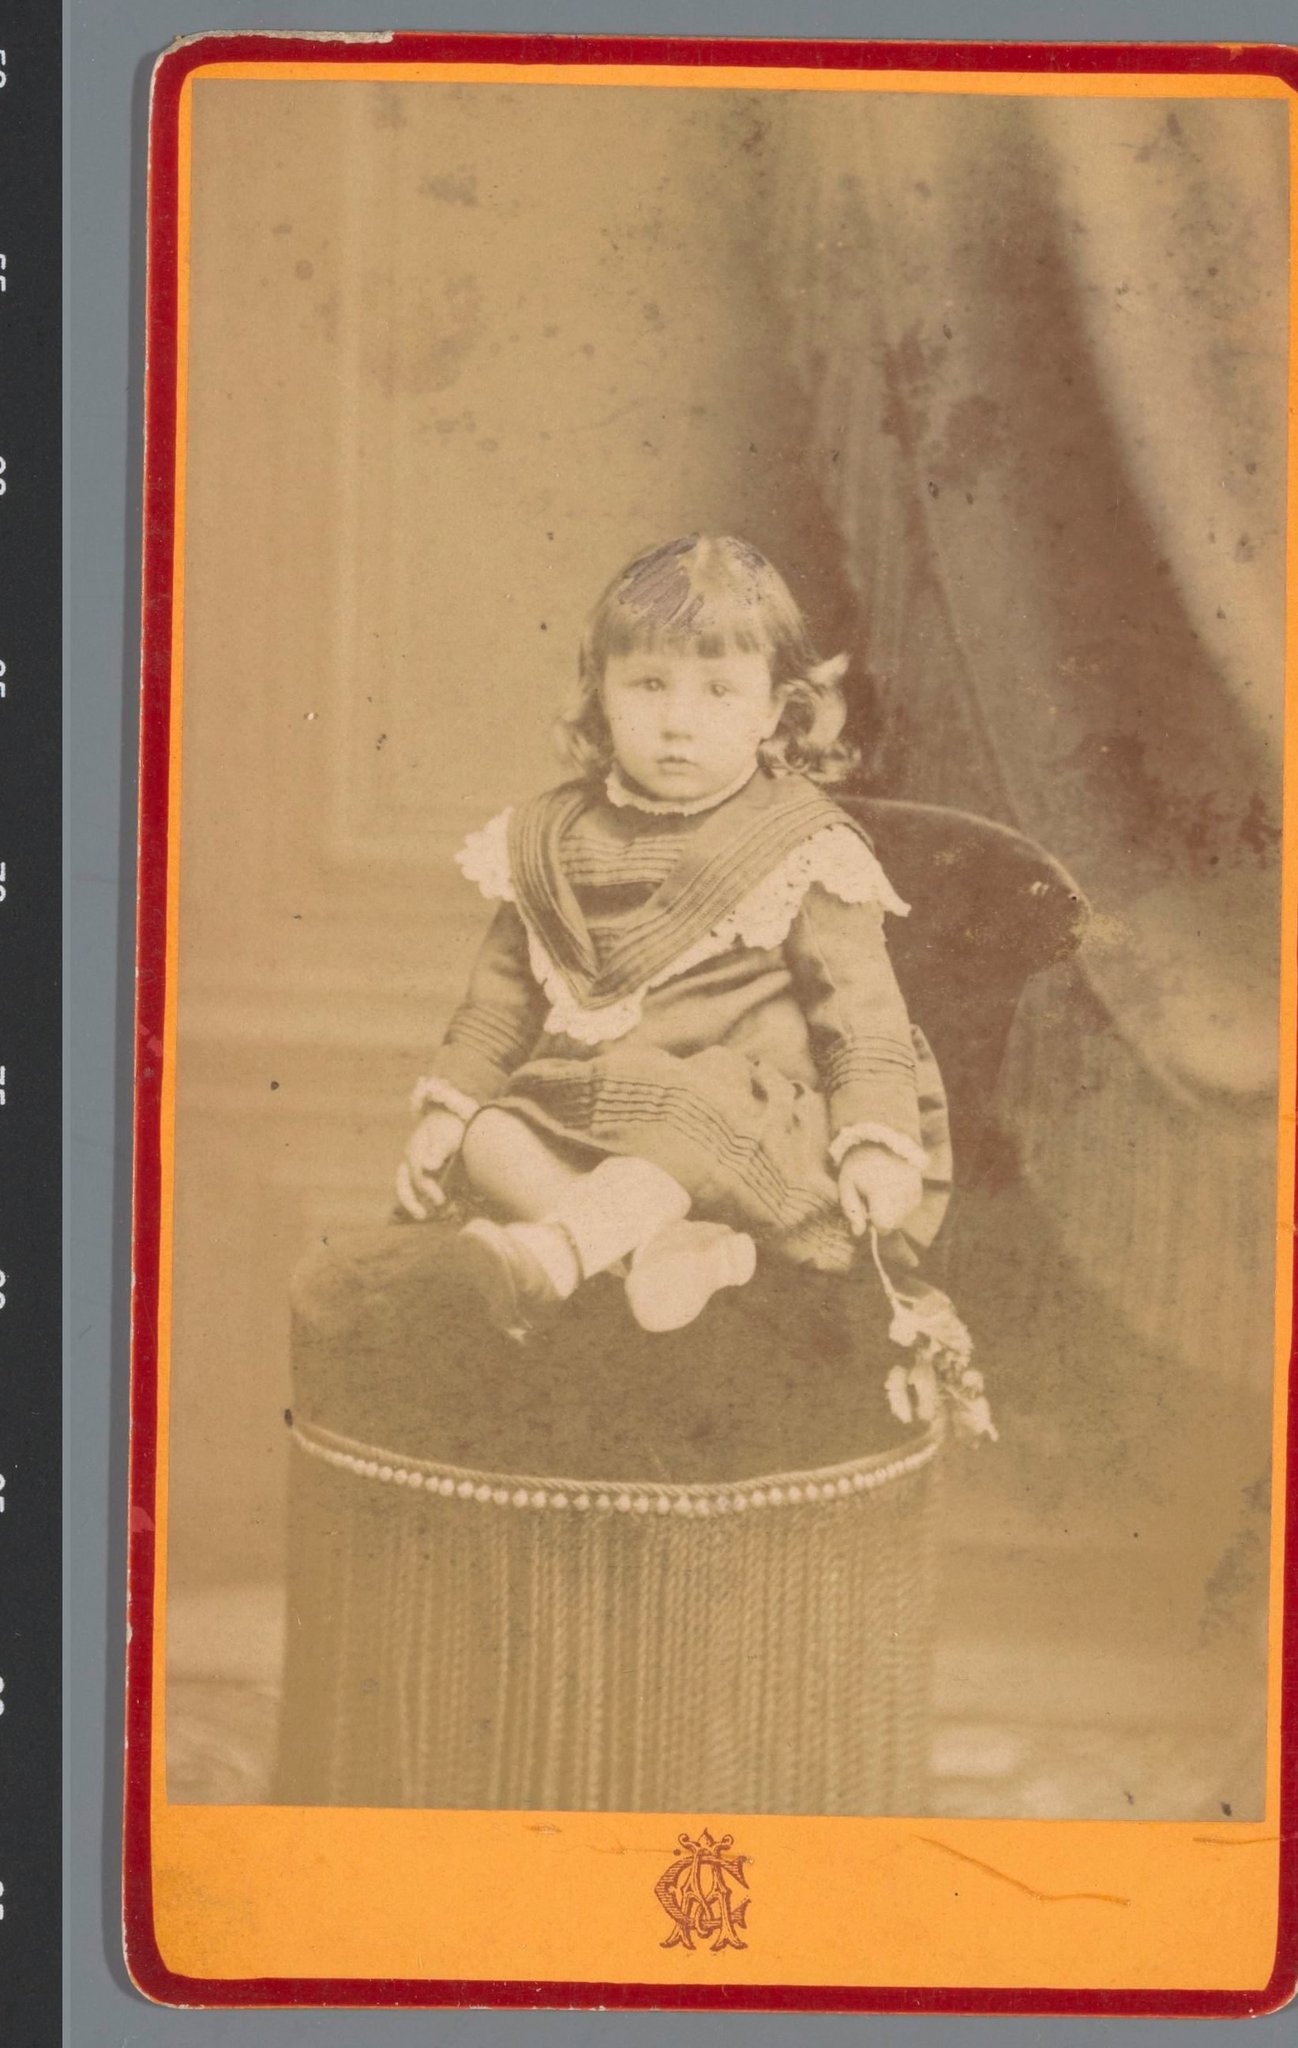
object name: carte de visite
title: Portret van een onbekend kind op een stoel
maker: angelo maria alessio caccia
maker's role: fotograaf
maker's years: 1802-1877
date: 1868-1890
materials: cardboard, paper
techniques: albumen print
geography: le havre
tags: child, anonymous historical person portrayed, le havre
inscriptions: inscription: ‘Art & Photographie/ A. Caccia/ Havre/ 126/ Boulevard de Strasbourg/ Paris/ 120/ Rue St. Lazare/ Les Clichés sont conservés.’, monogram: ‘AC’